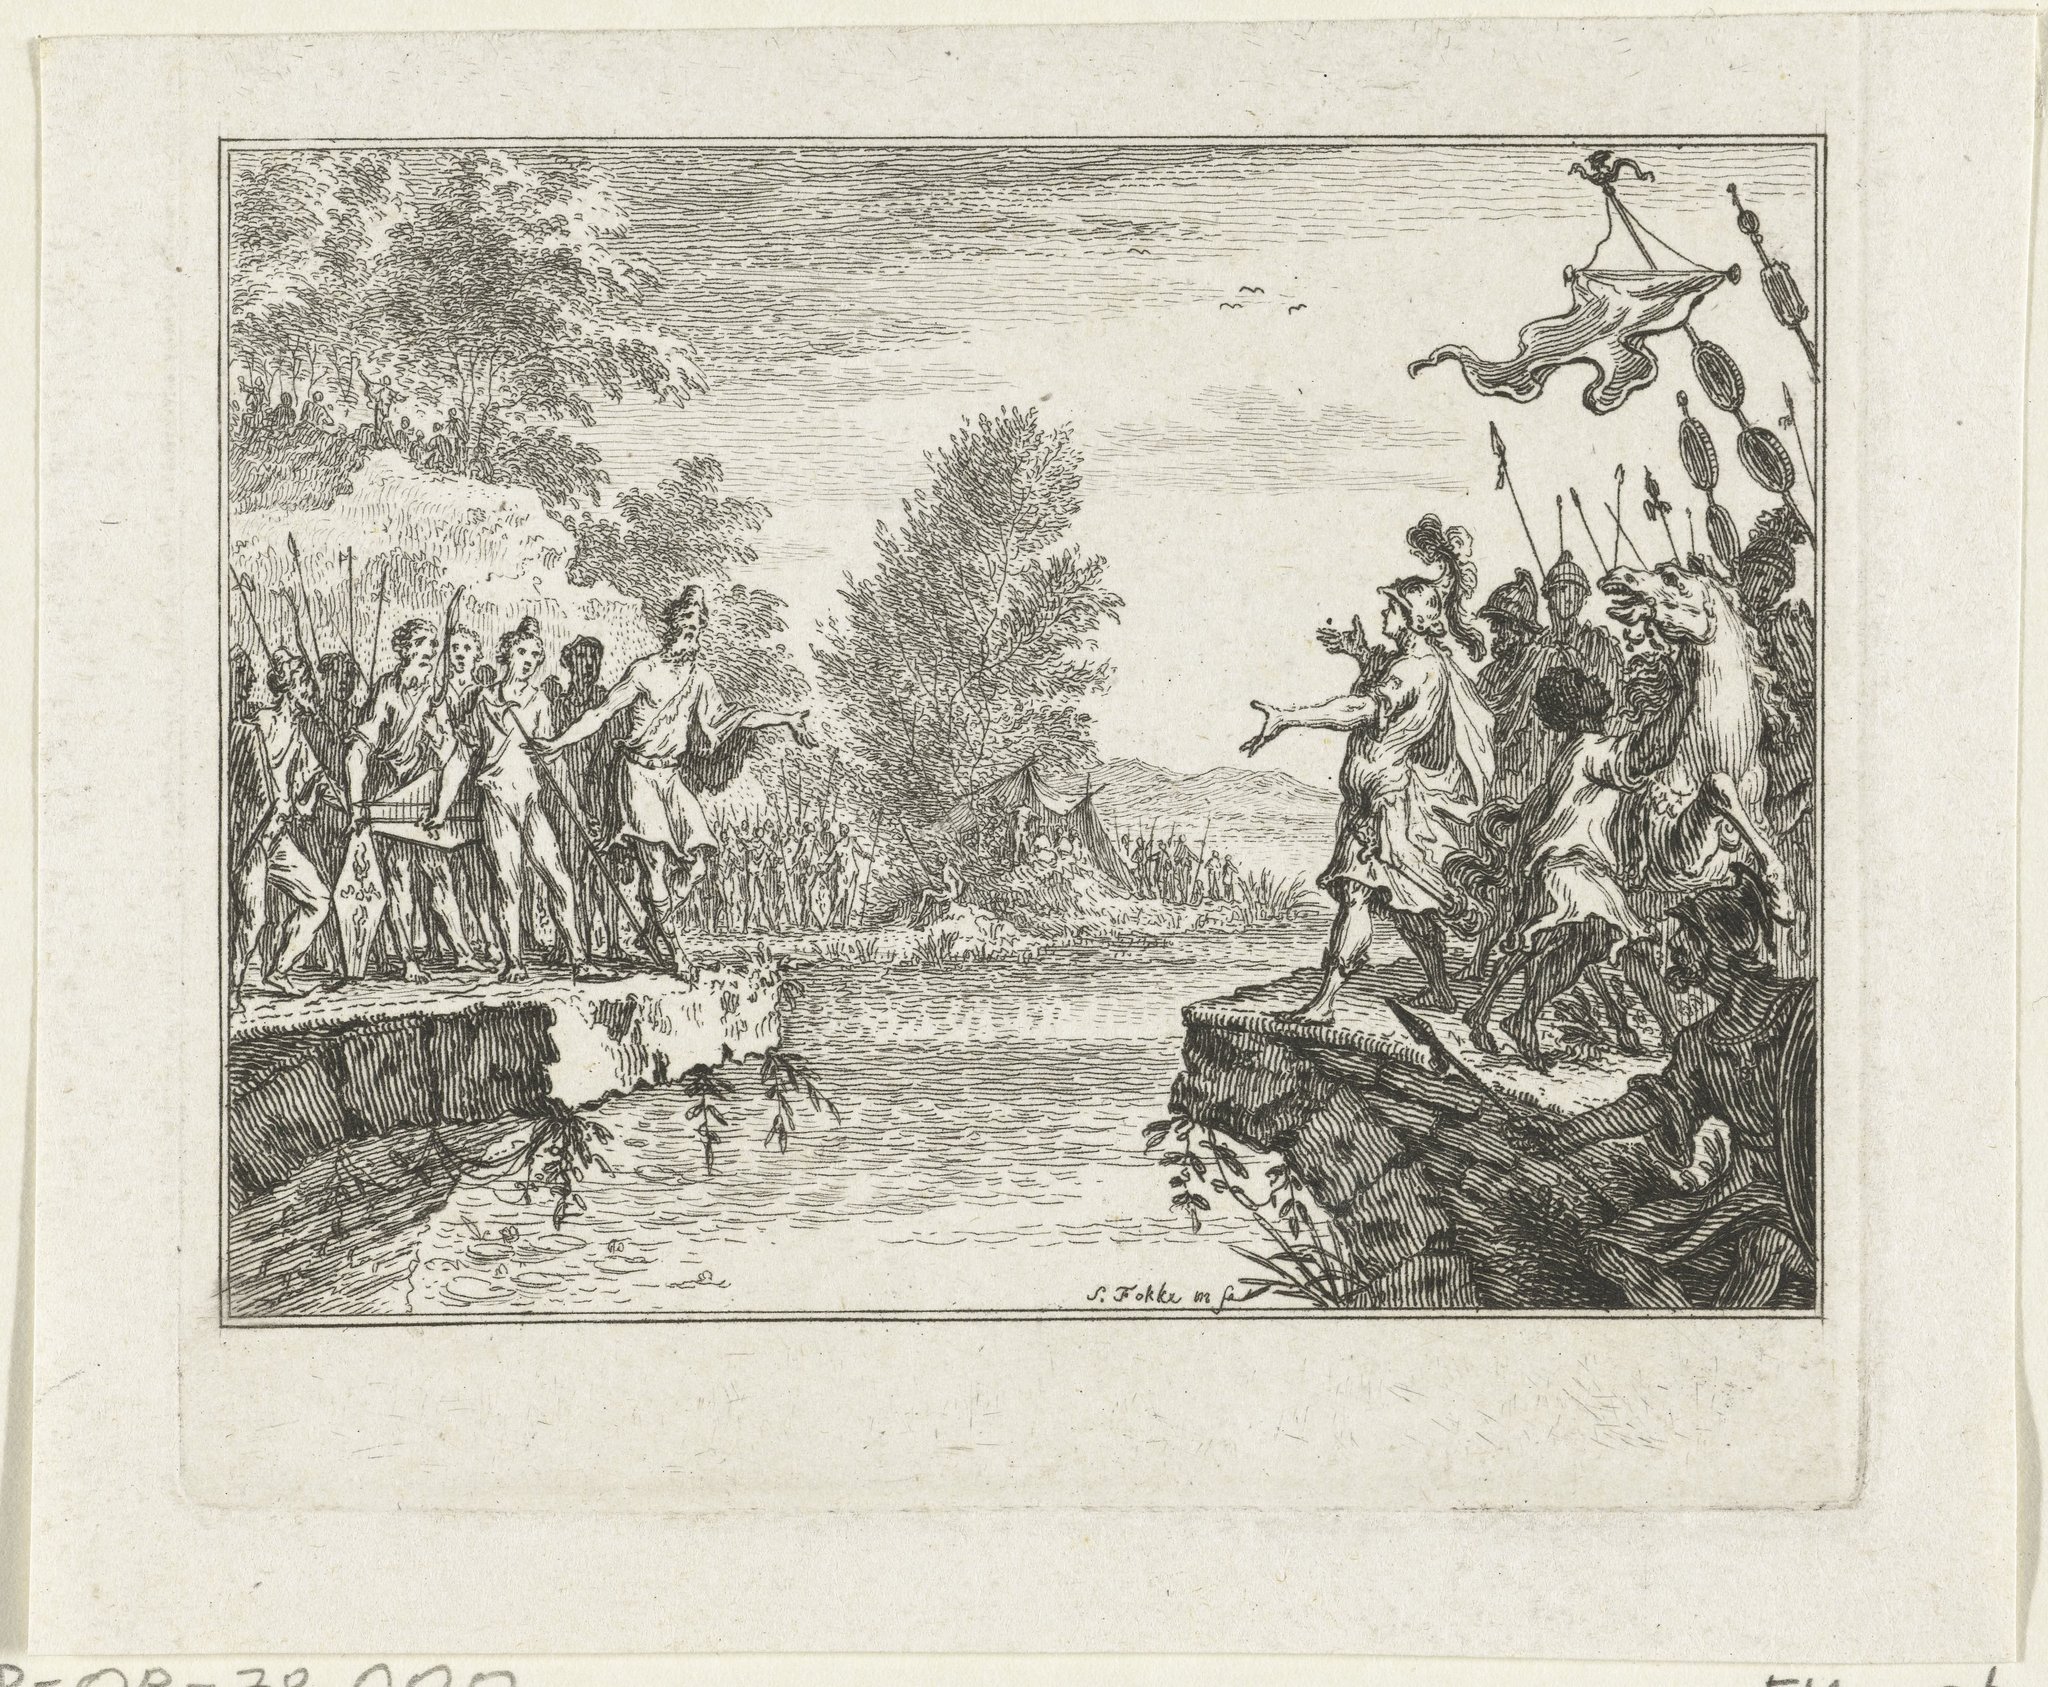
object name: history print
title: Civilis en Cerialis onderhandelen op de afgebroken brug, 69-70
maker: simon fokke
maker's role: draughtsman, print maker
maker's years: 1712-1784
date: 1782-1800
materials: paper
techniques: etching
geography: netherlands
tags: peace negotiations, extinct, 'historical' peoples (with name), netherlands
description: Illustratie voor een onbekend werk, later hergebruikt in: J.W. te Water, De vaderlandsche Historie van den heere J. Wagenaar, verkort, en met leerzaame aanmerkingen, ten dienste der Nederlandsche jeugd, 1784-1800, 4 delen, pl. IV, blz. 44. Staat vóór de letter. Niet in Frederik Muller; door het RPK toegevoegd nummer.